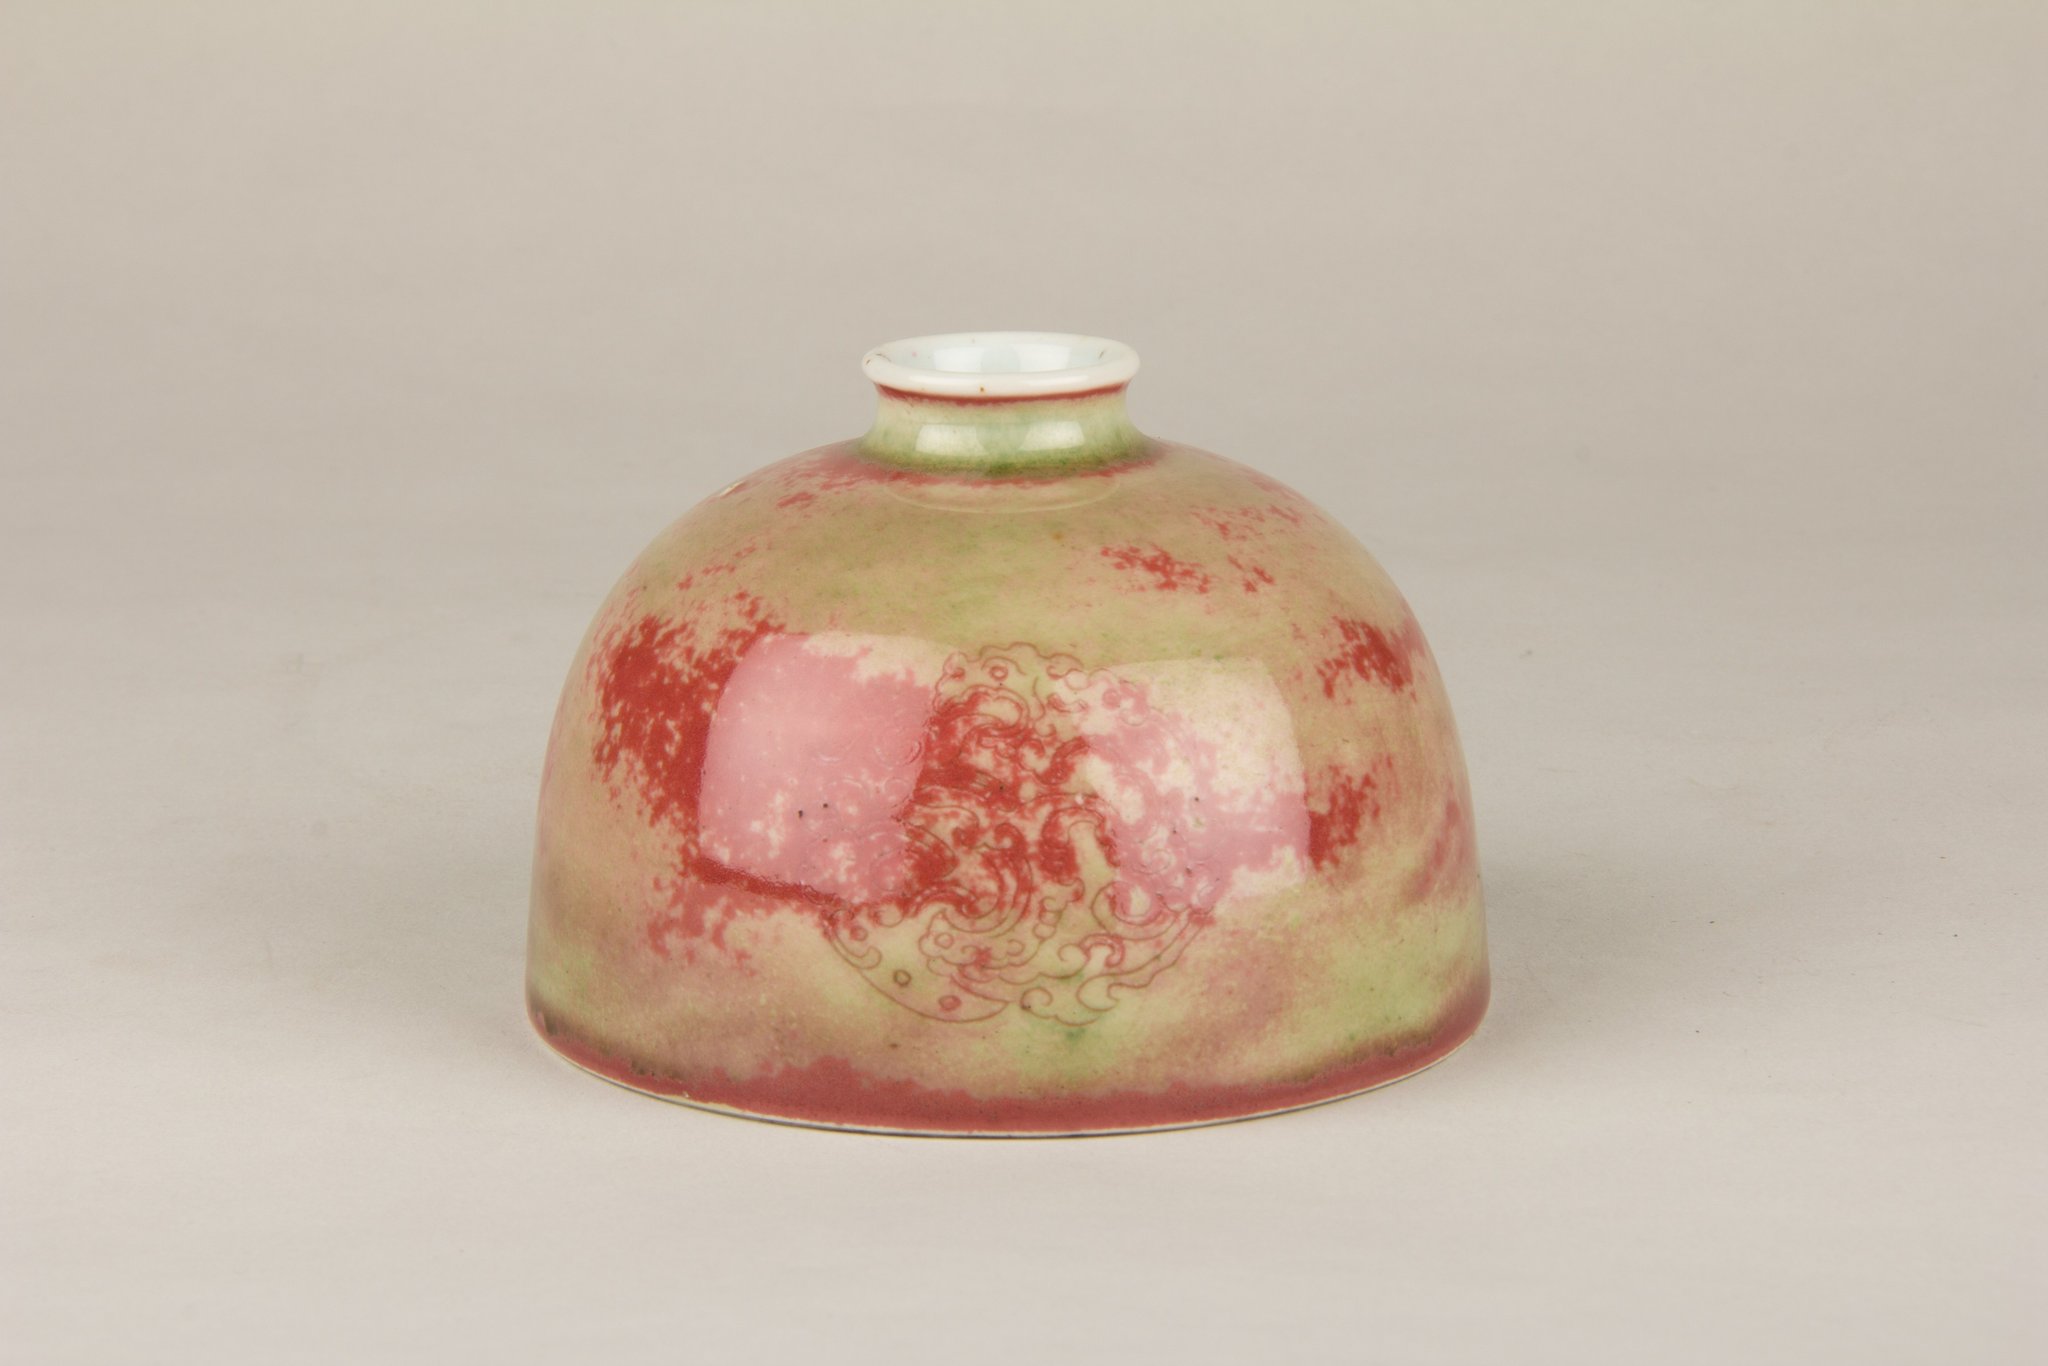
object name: writer's water bottle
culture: chinese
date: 1662-1722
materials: porcelain